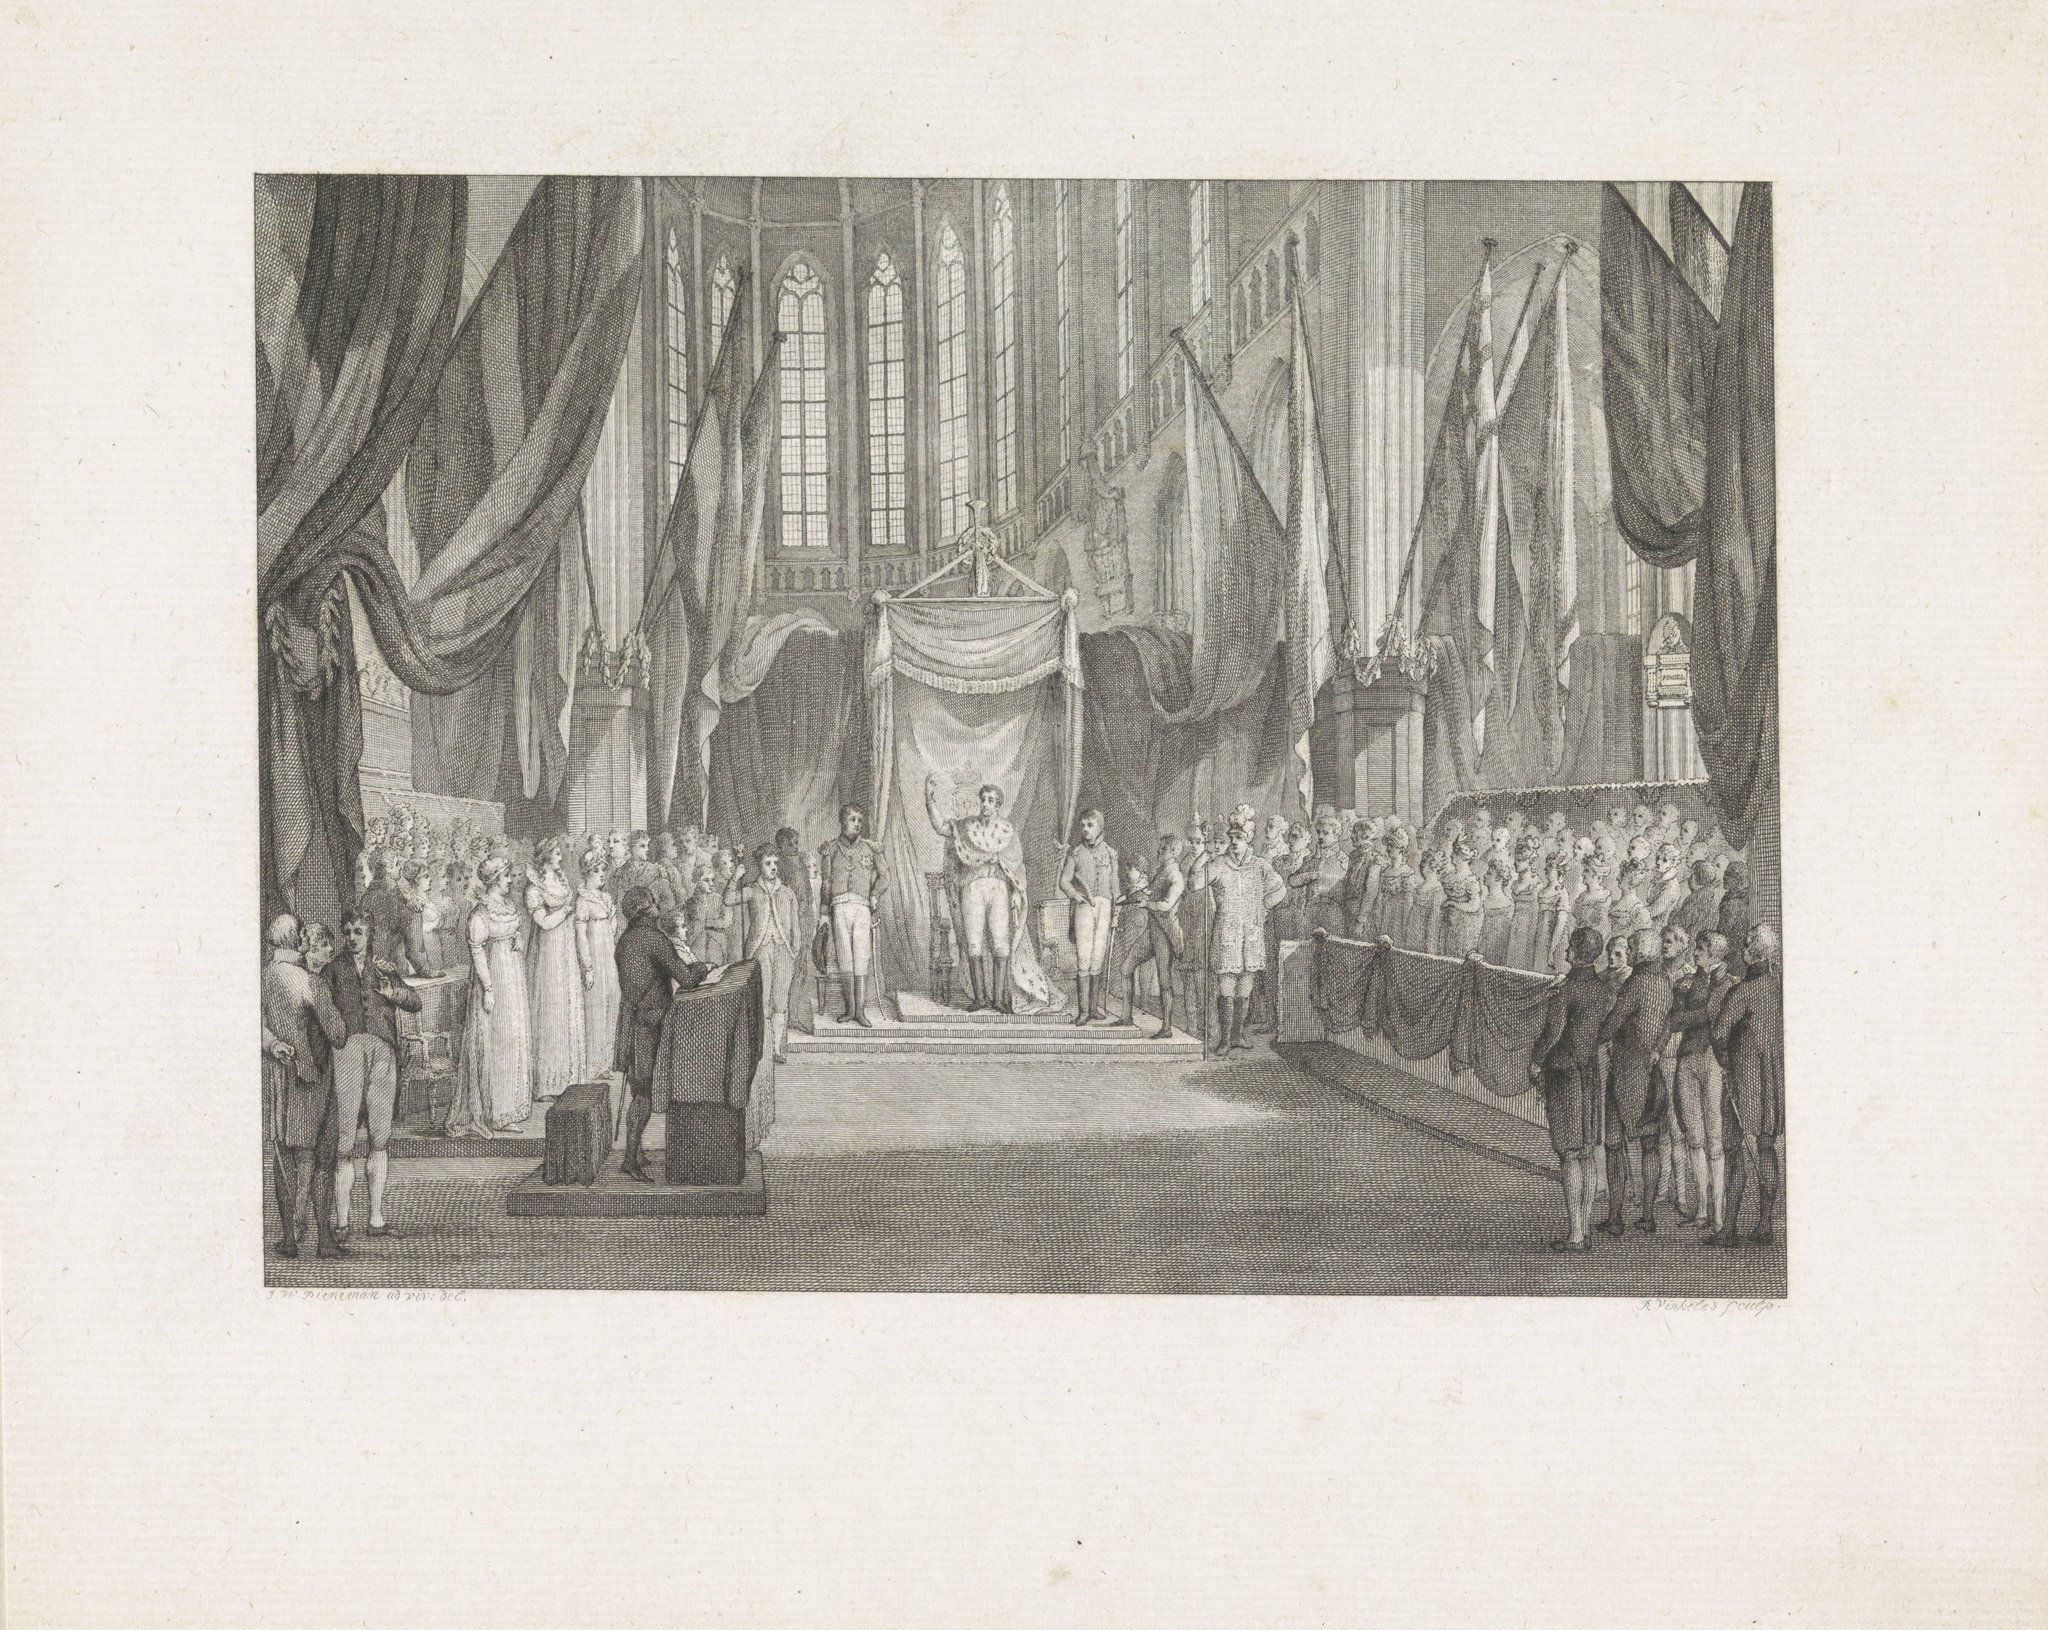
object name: print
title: Inhuldiging van Willem Frederik, prins van Oranje als souverein vorst, 1814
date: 1814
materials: paper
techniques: engraving, etching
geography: netherlands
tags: the hague, william i of the netherlands, ceremonial celebration of installation of a ruler, new ruler taking the oath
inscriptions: collector's mark: Lugt 2228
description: Gebruikt als illustratie in: R. Metelerkamp. De regeringsvorm der Vereenigde Nederlanden, na de verheffing van Prins Willem Frederik van Oranje-Nassau tot souvereinen vorst. 's-Gravenhage : J. Allart, 1814.